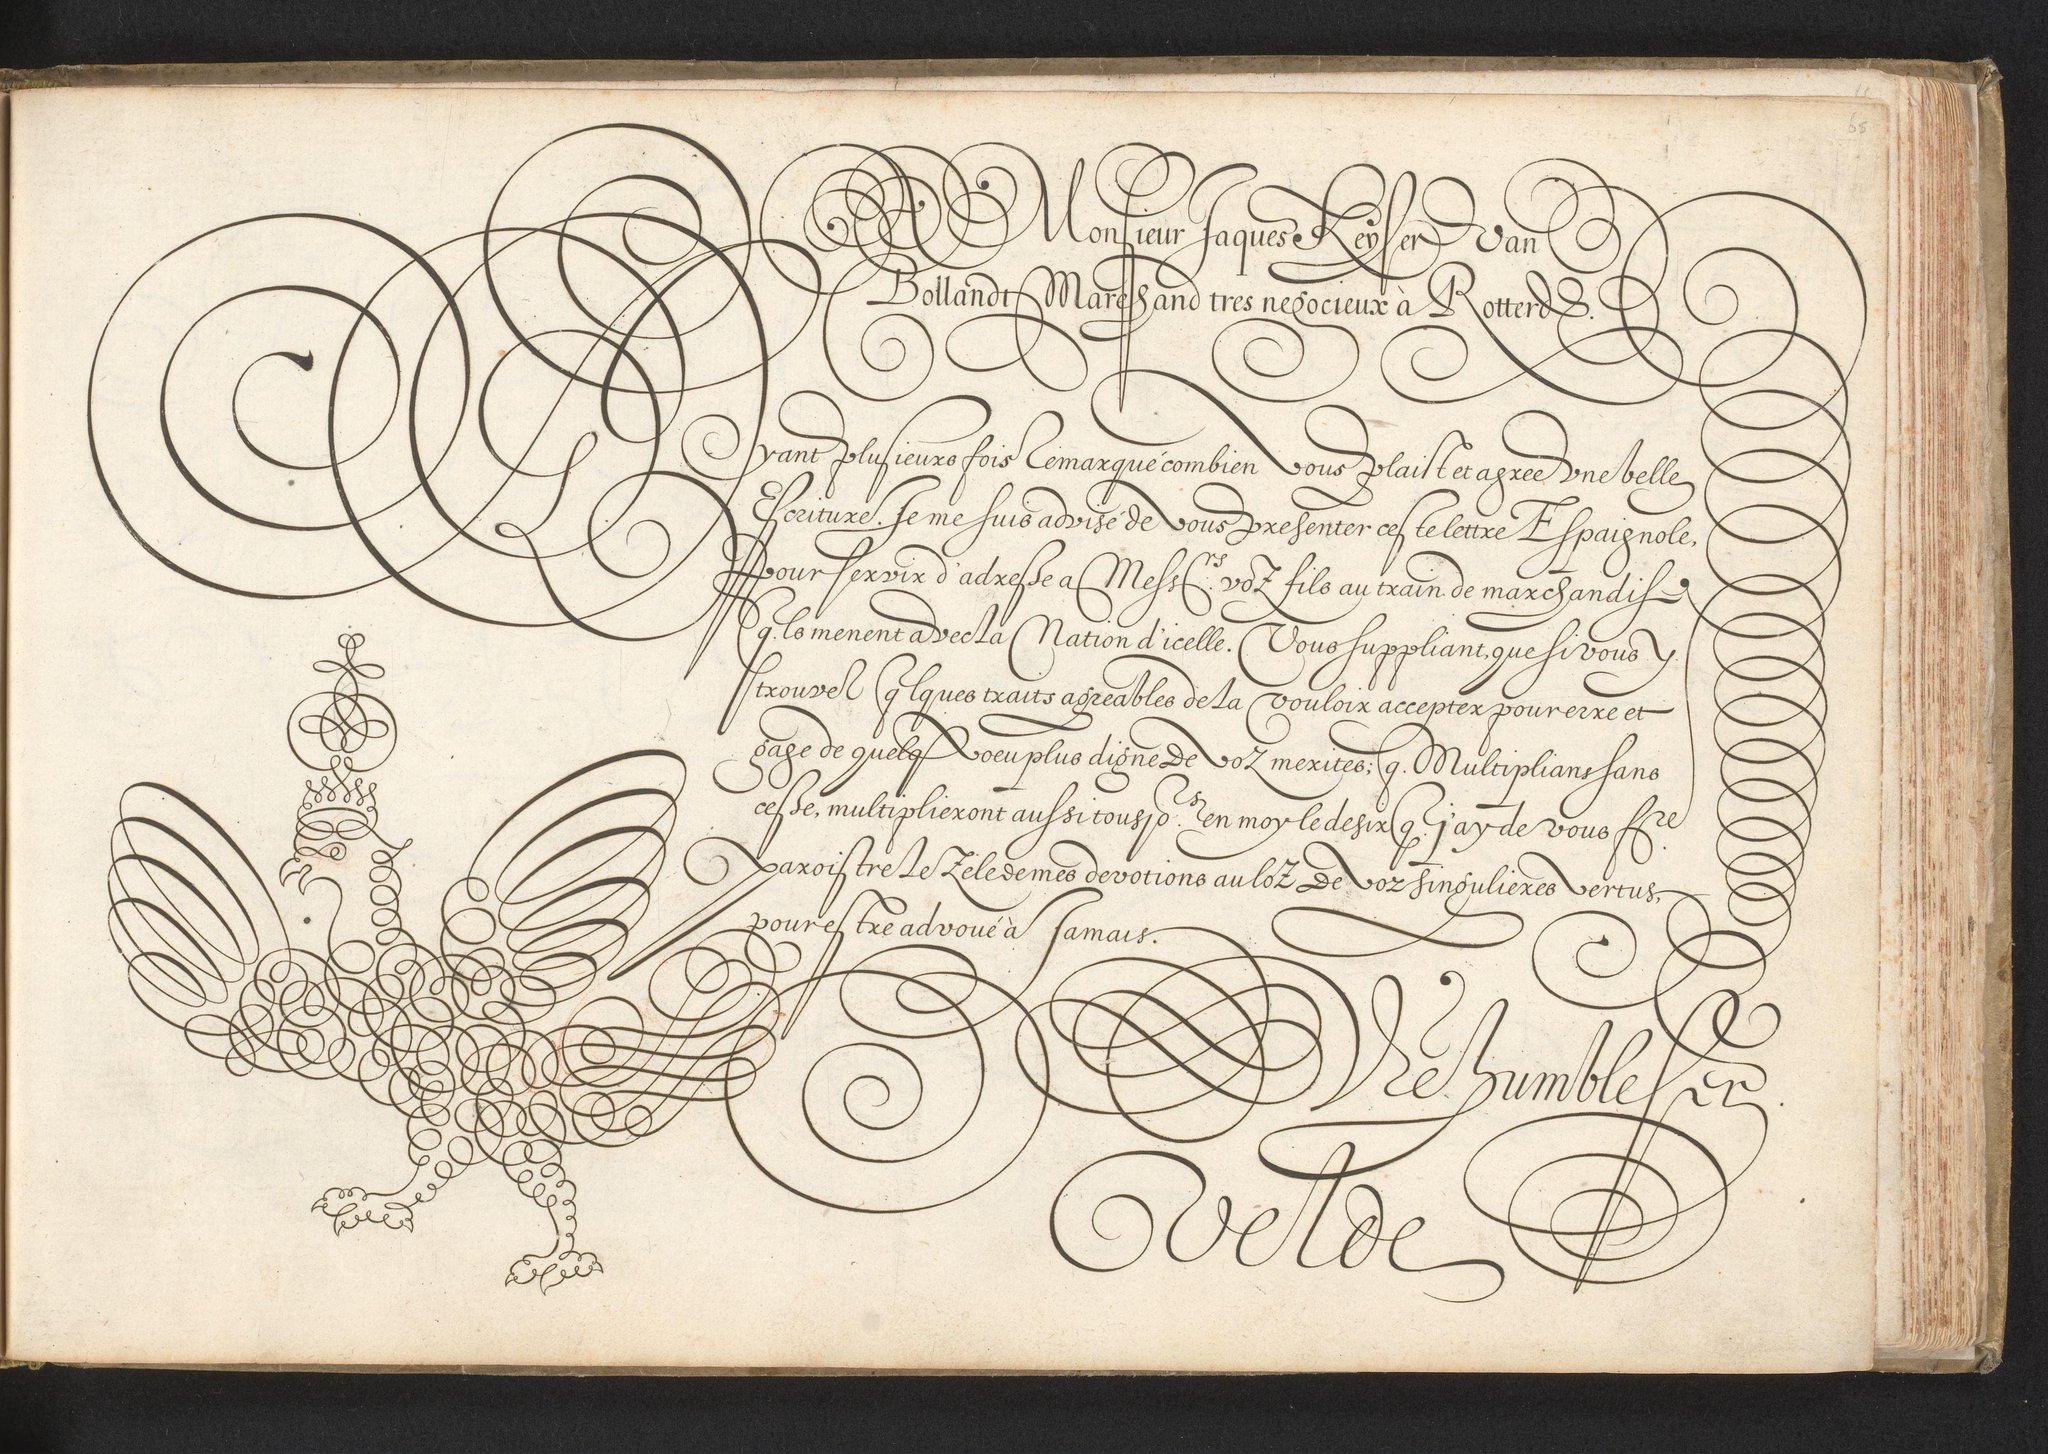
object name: ornament print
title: Spieghel der schrijfkonste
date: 1605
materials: paper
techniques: engraving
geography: rotterdam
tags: fowl (cock, hen, chicken, etc.), calligraphy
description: Schrijfvoorbeeld met de aanhef: A monsieur Jacques Keyser van Bollandt marchand tres negocieux à Rotterd[am]. Daaronder negen regels tekst in het Frans: Ayant plusieurs ... Aan de linkerkant een adelaar in krulwerk. De prent maakt deel uit van een album.